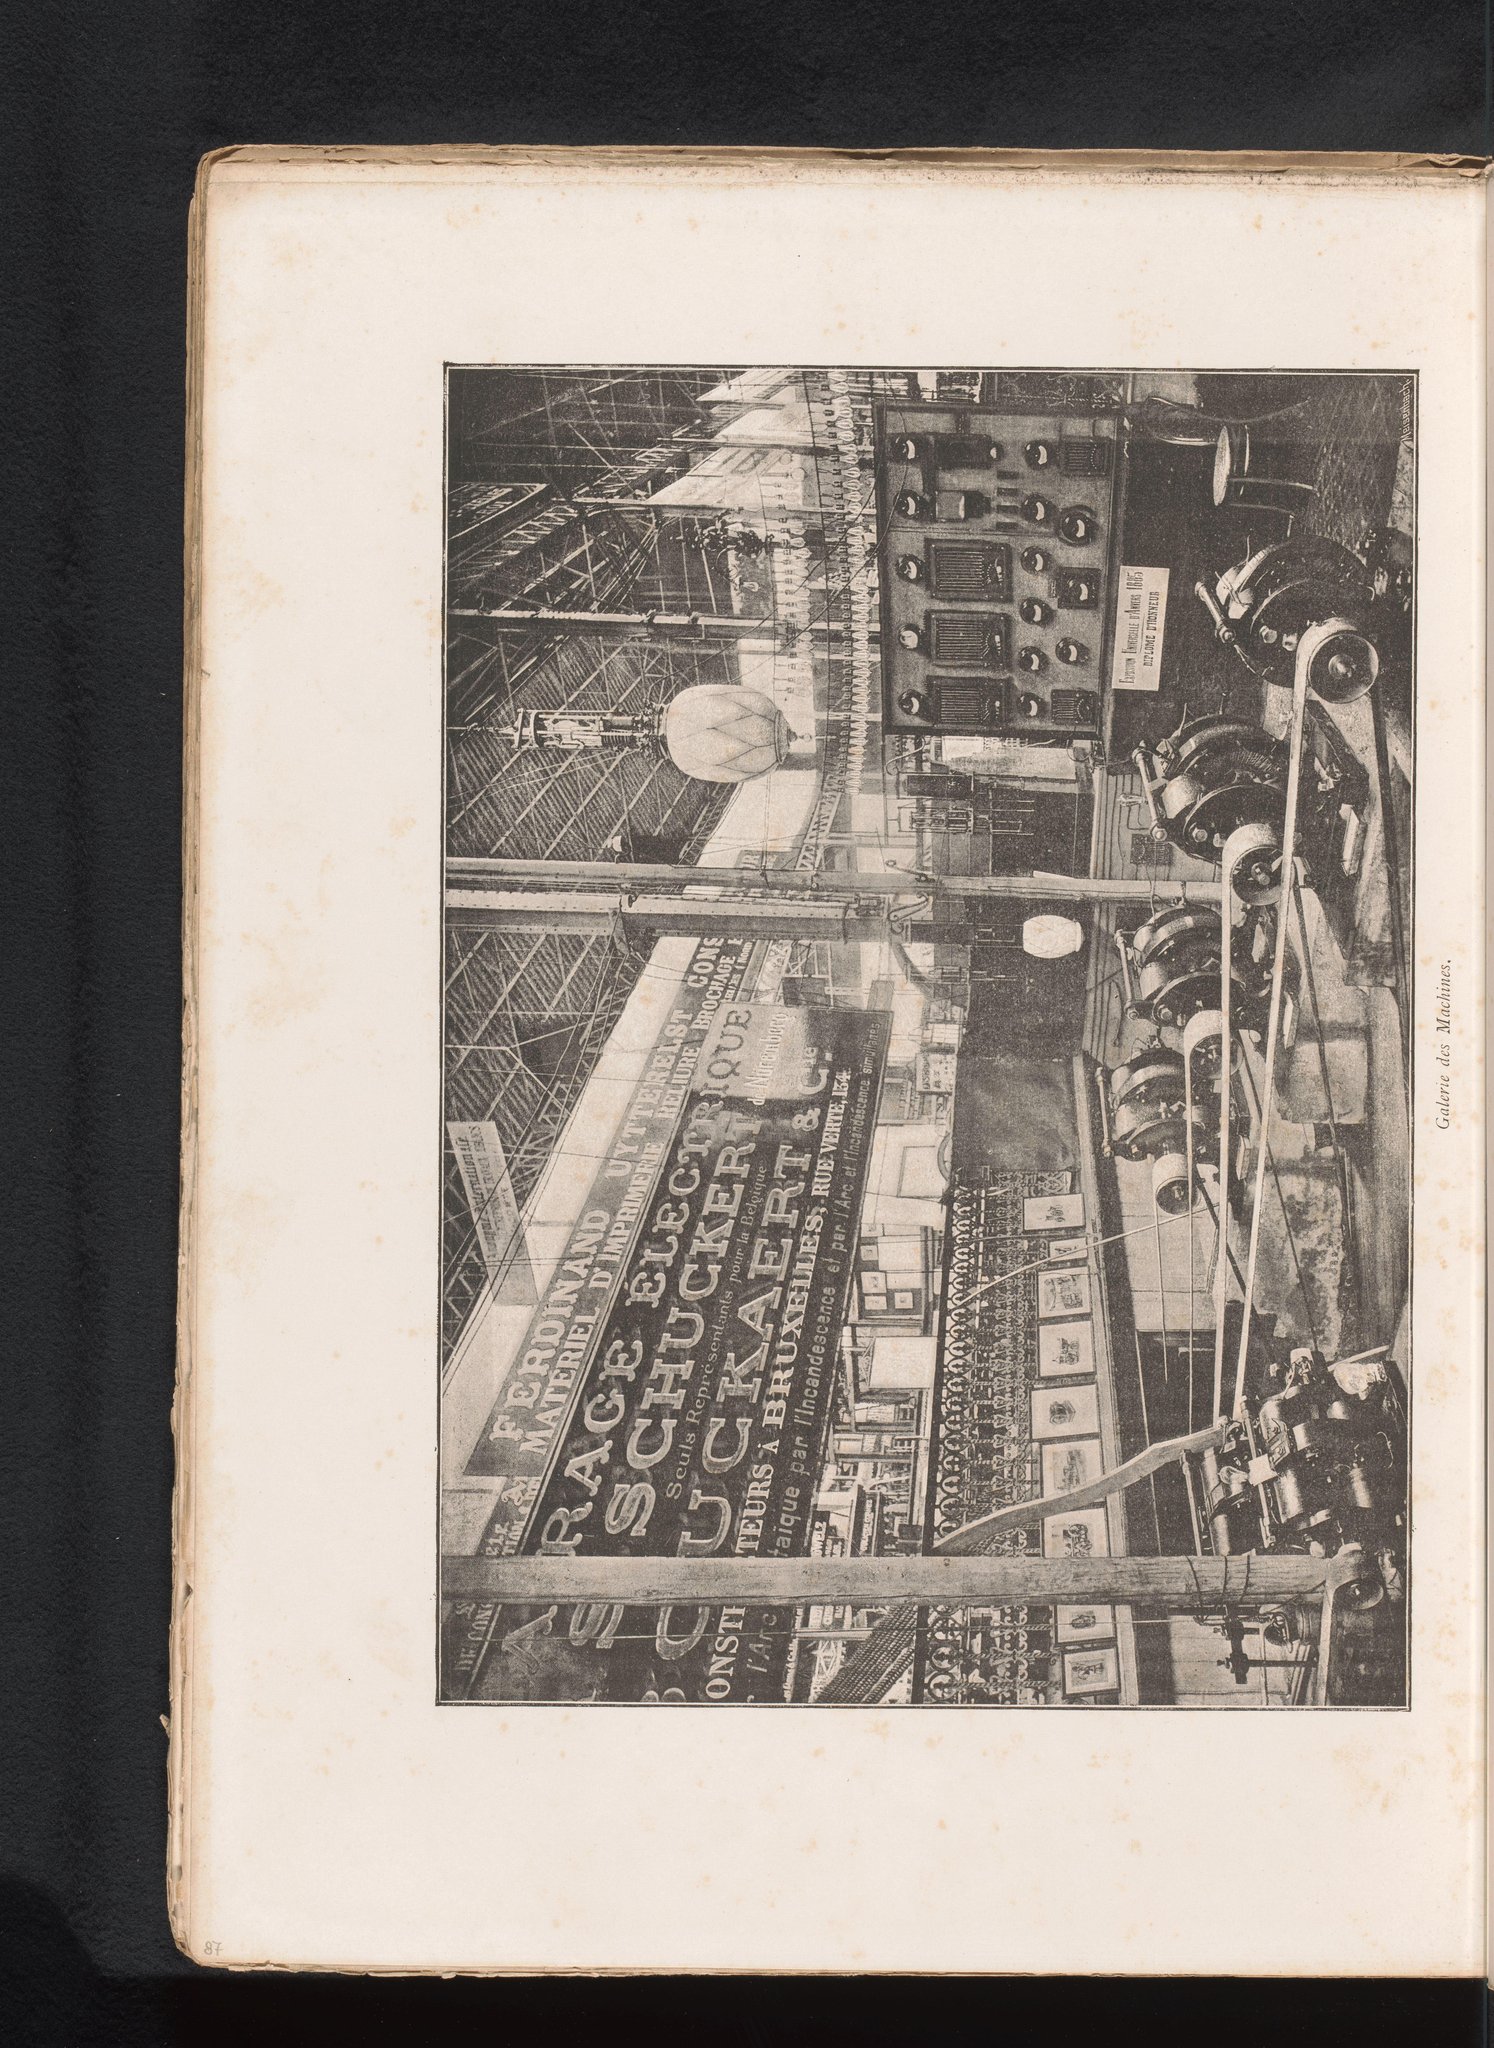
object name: photomechanical print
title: Gezicht op de galerij met machines op de Wereldtentoonstelling van 1885 in Antwerpen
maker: Anonymous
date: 1880-1885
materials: paper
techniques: autotype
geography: antwerp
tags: world fair, world exhibition, antwerp